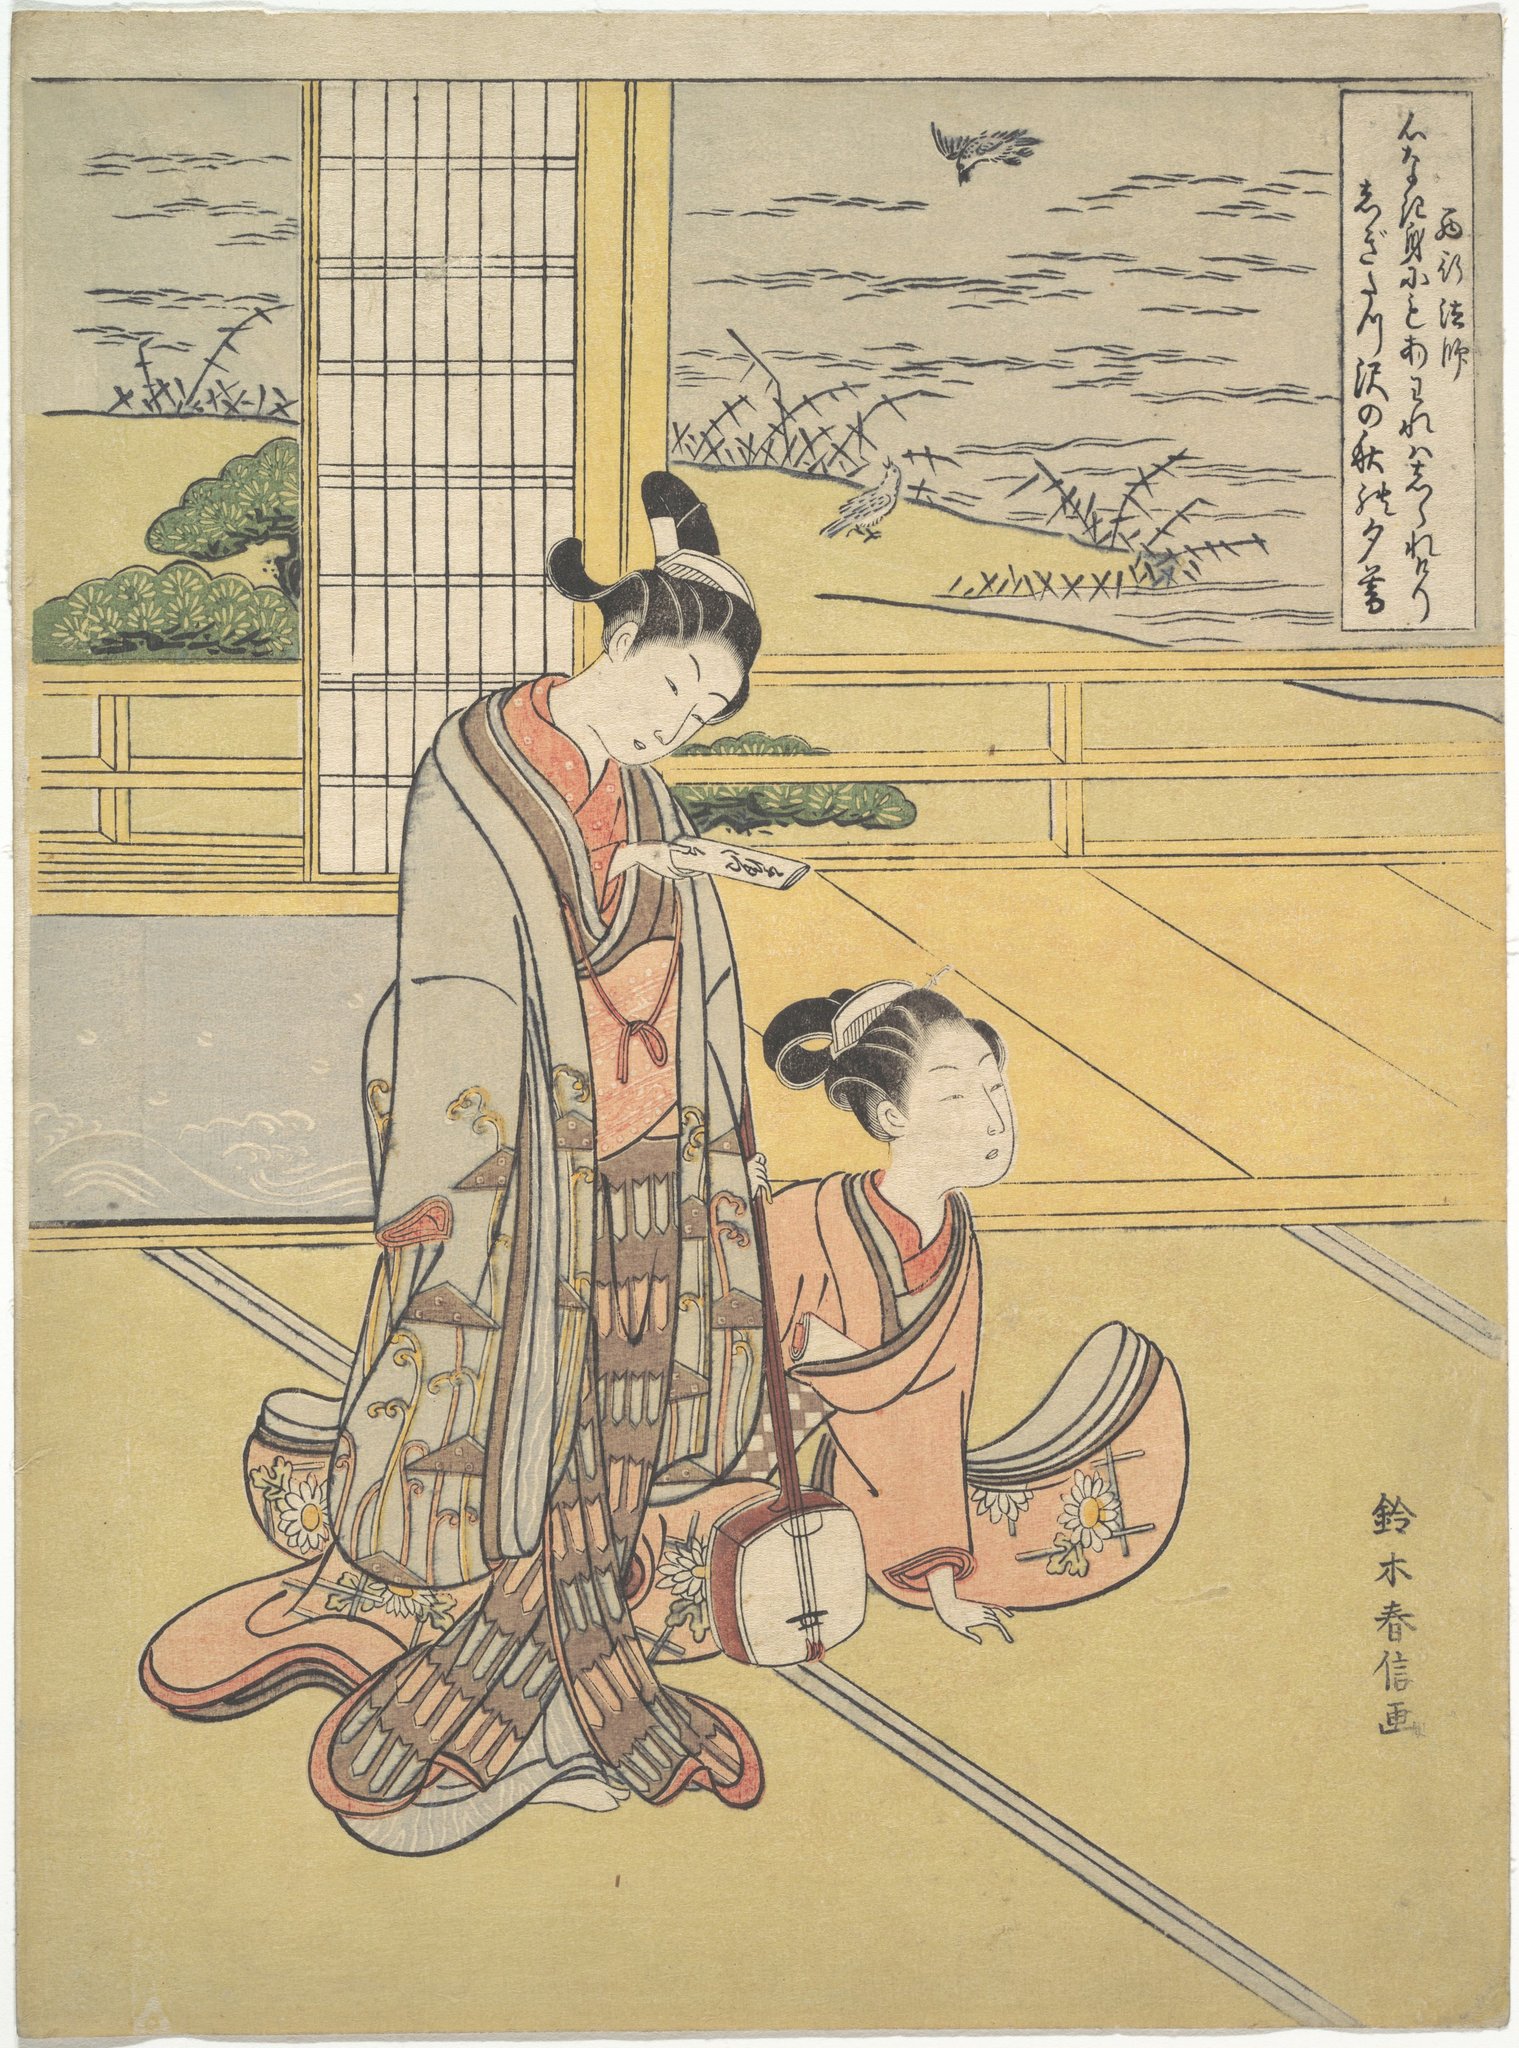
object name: print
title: A Young Man and Woman with a Shamisen; Monk Saigyō, from a series alluding to the Three Evening Poems (Sanseki waka)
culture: japanese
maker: suzuki harunobu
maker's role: artist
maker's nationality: japanese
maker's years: 1725-1770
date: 1768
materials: ink, paper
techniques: woodblock print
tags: poetry,men,women